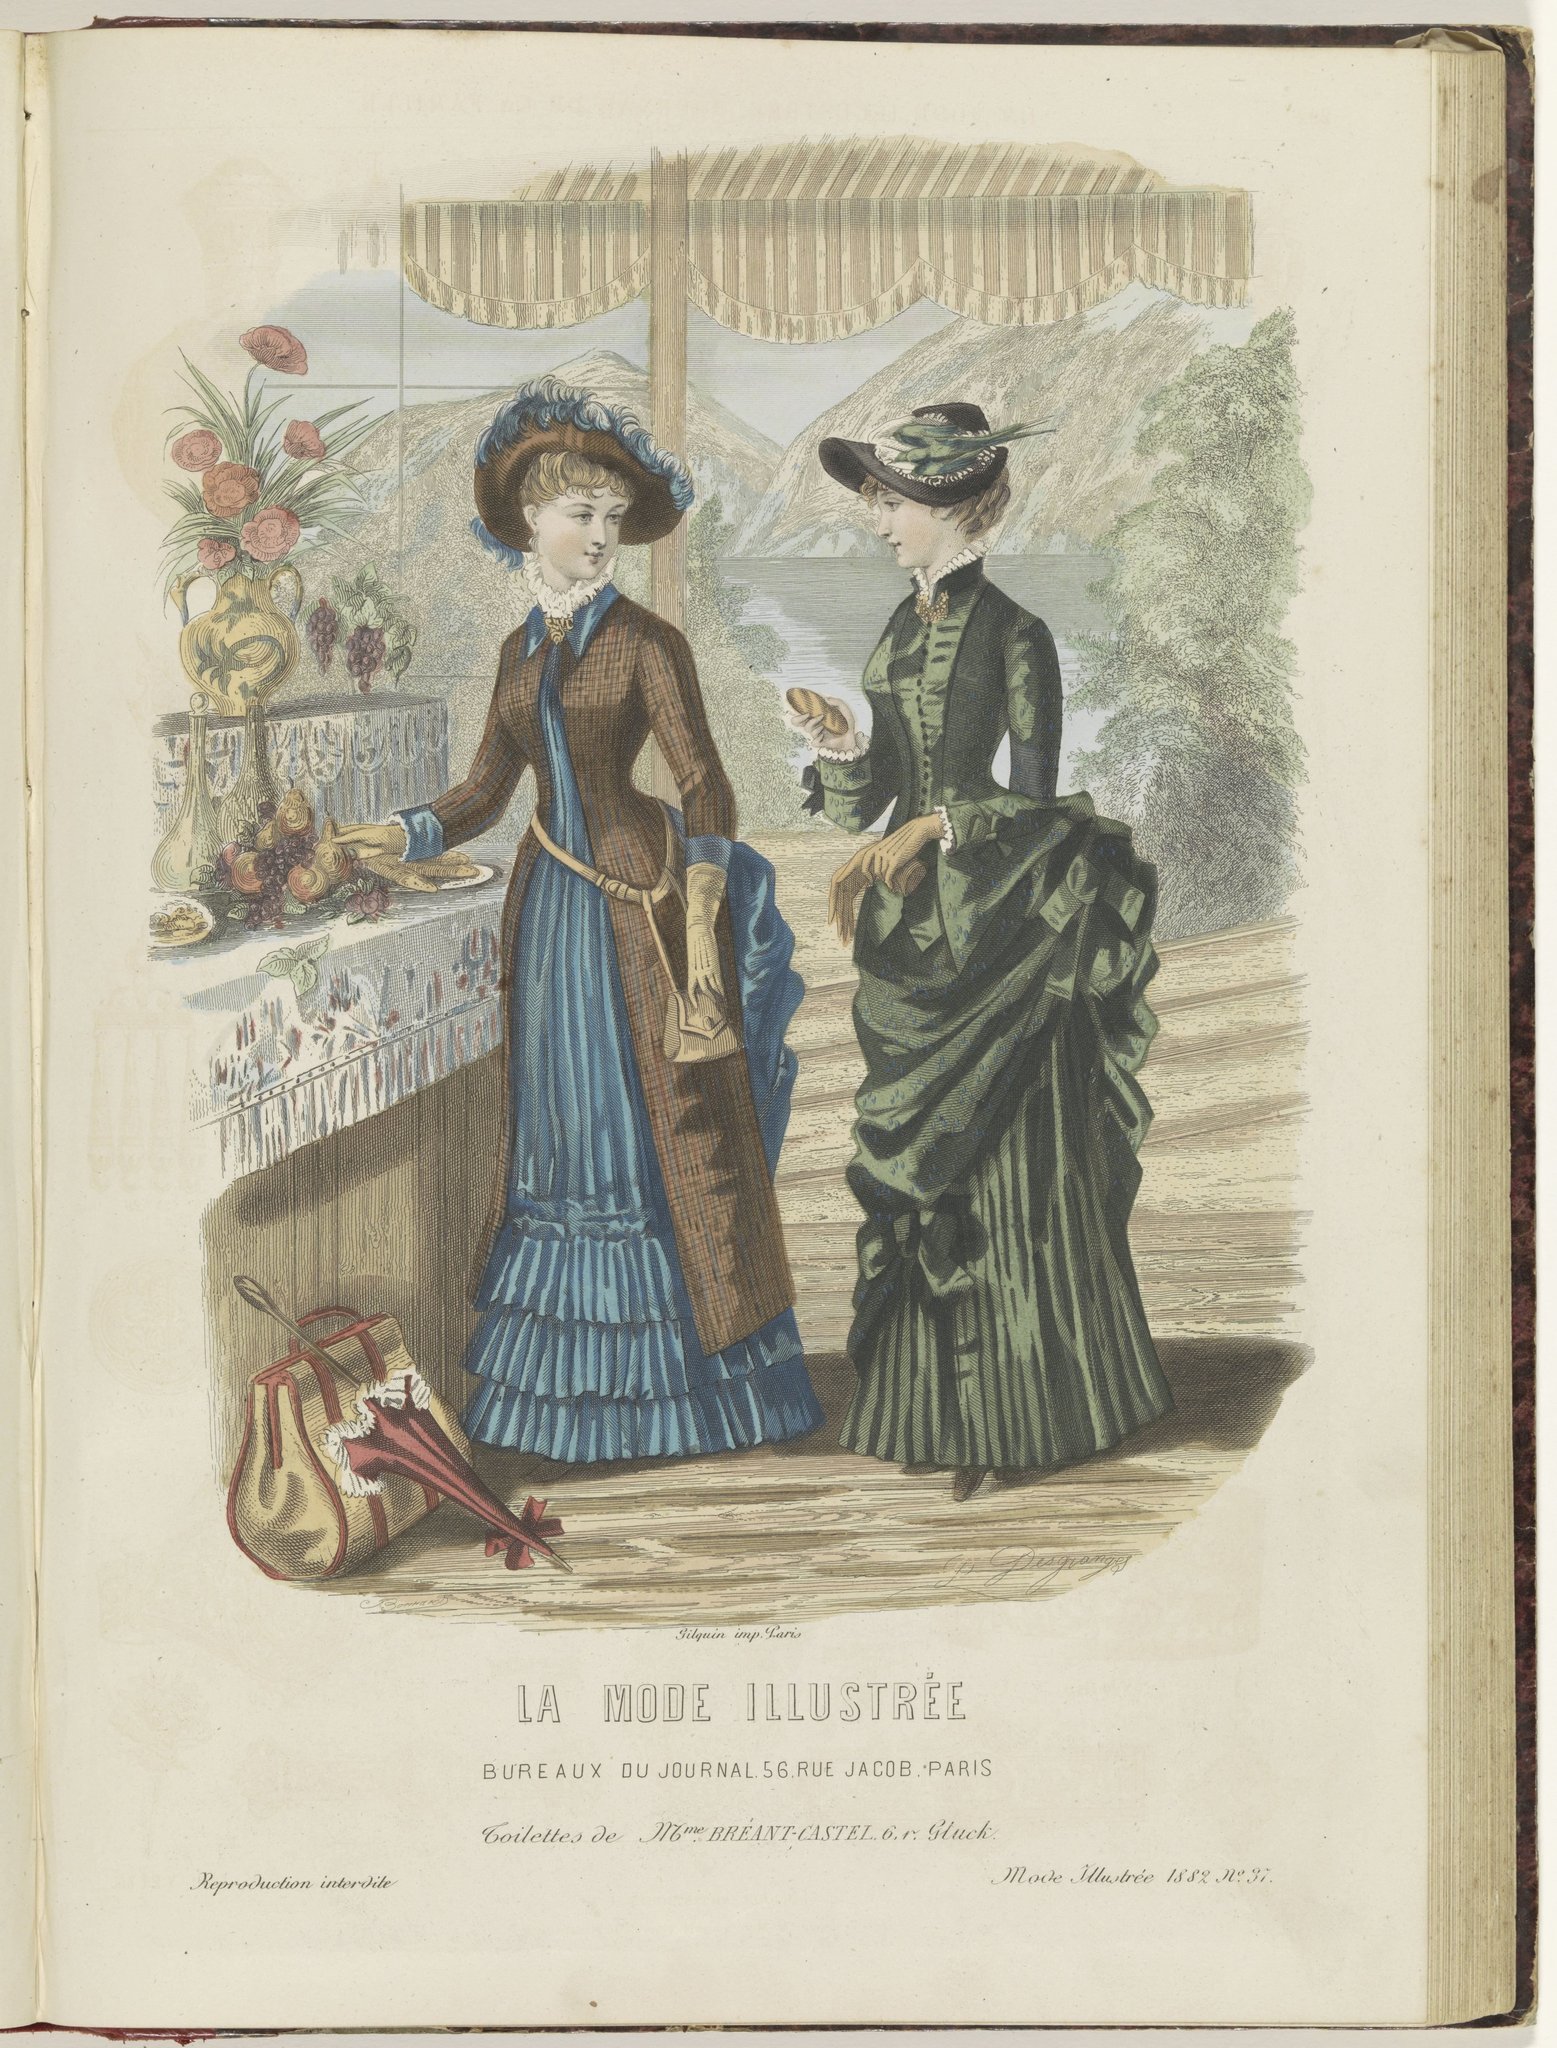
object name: magazine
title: La Mode Illustrée, Journal de la Famille, 1882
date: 1882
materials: paper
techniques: engraving, hand coloring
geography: paris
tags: fashion plates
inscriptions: date